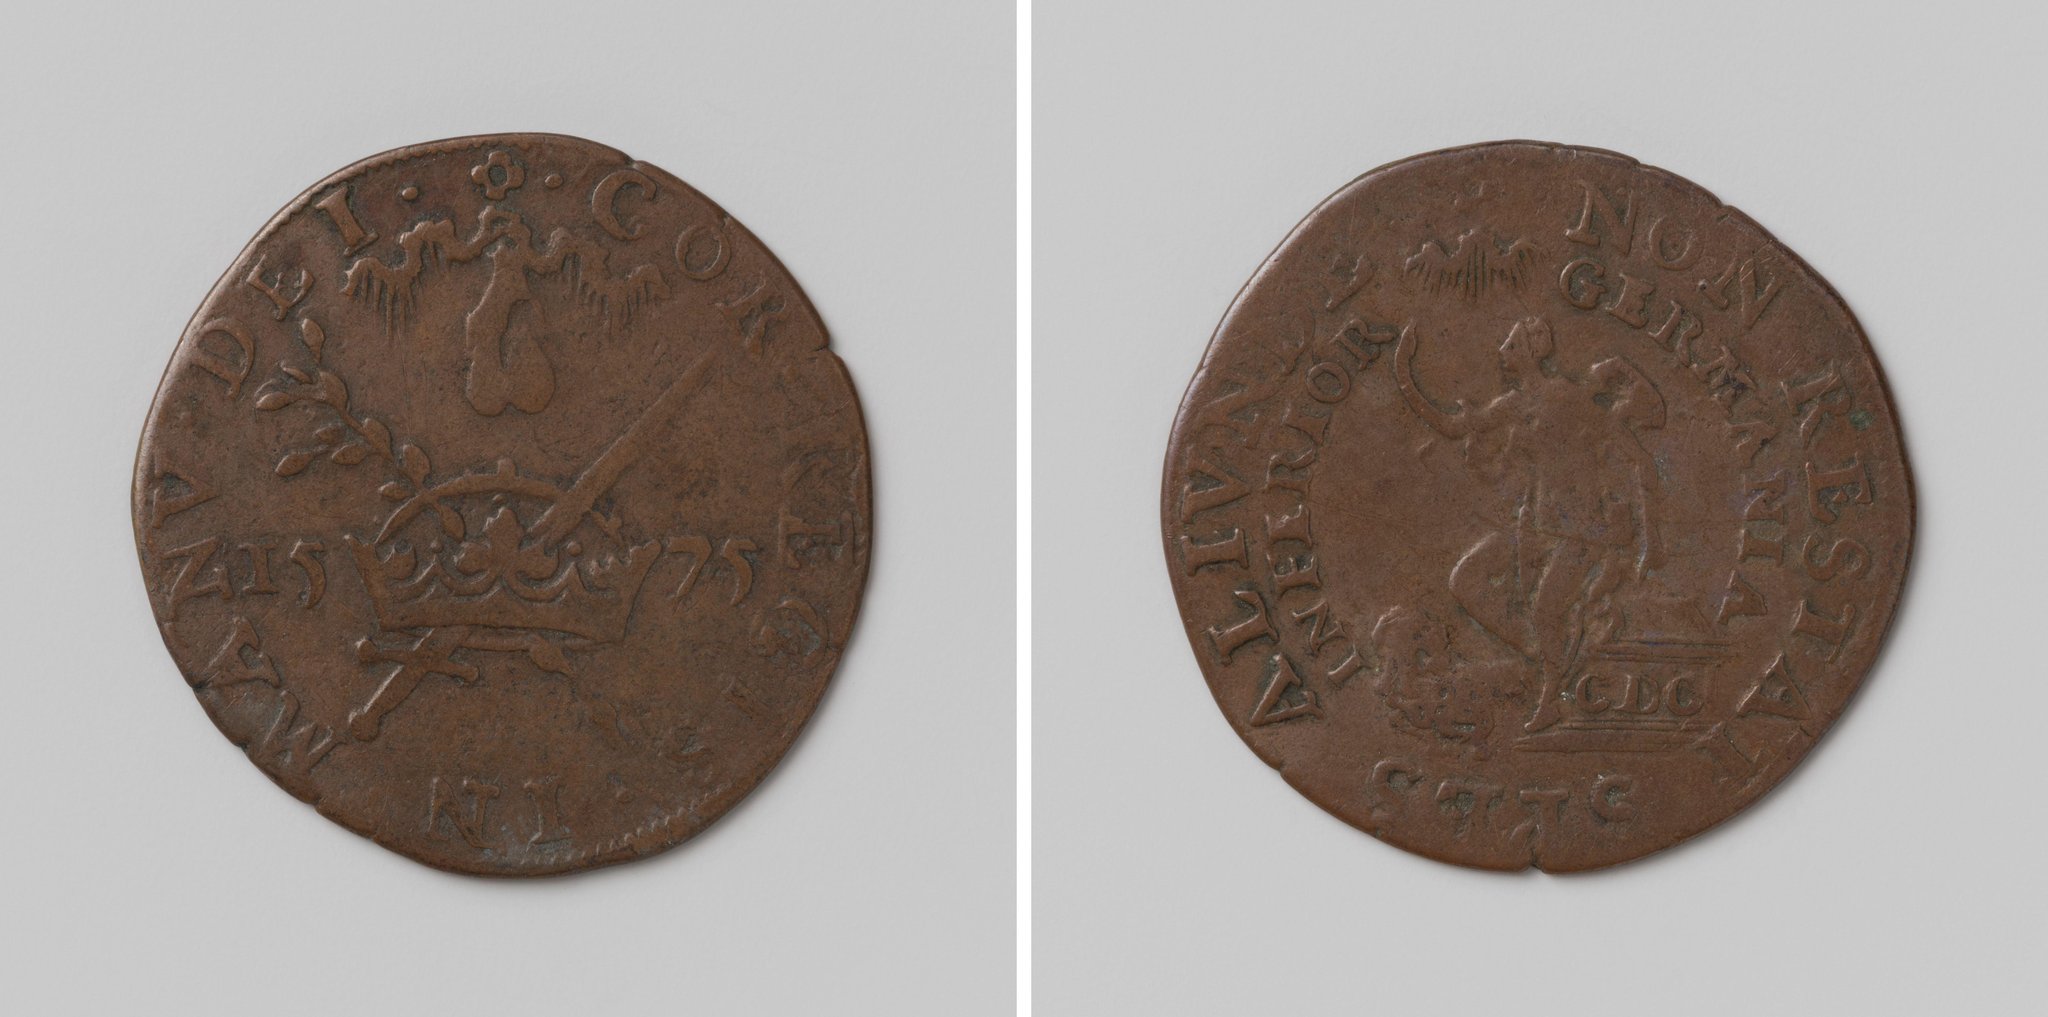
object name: jeton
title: Chaotische toestand in de Nederlanden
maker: Anonymous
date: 1575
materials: copper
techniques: striking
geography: netherlands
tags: netherlands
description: Koperen penning. Voorzijde: kroon tussen jaartal op gekruist zwaard en olijftak, waarboven hand uit wolken hart houdt binnen omschrift. Keerzijde: vrouw, voorstellende de Nederlanden, zittend op sokkel, met geheven rechterhand kijkt omhoog naar zon, die door wolken breekt; aan haar voeten liggende leeuw binnen tweeregelig omschrift.